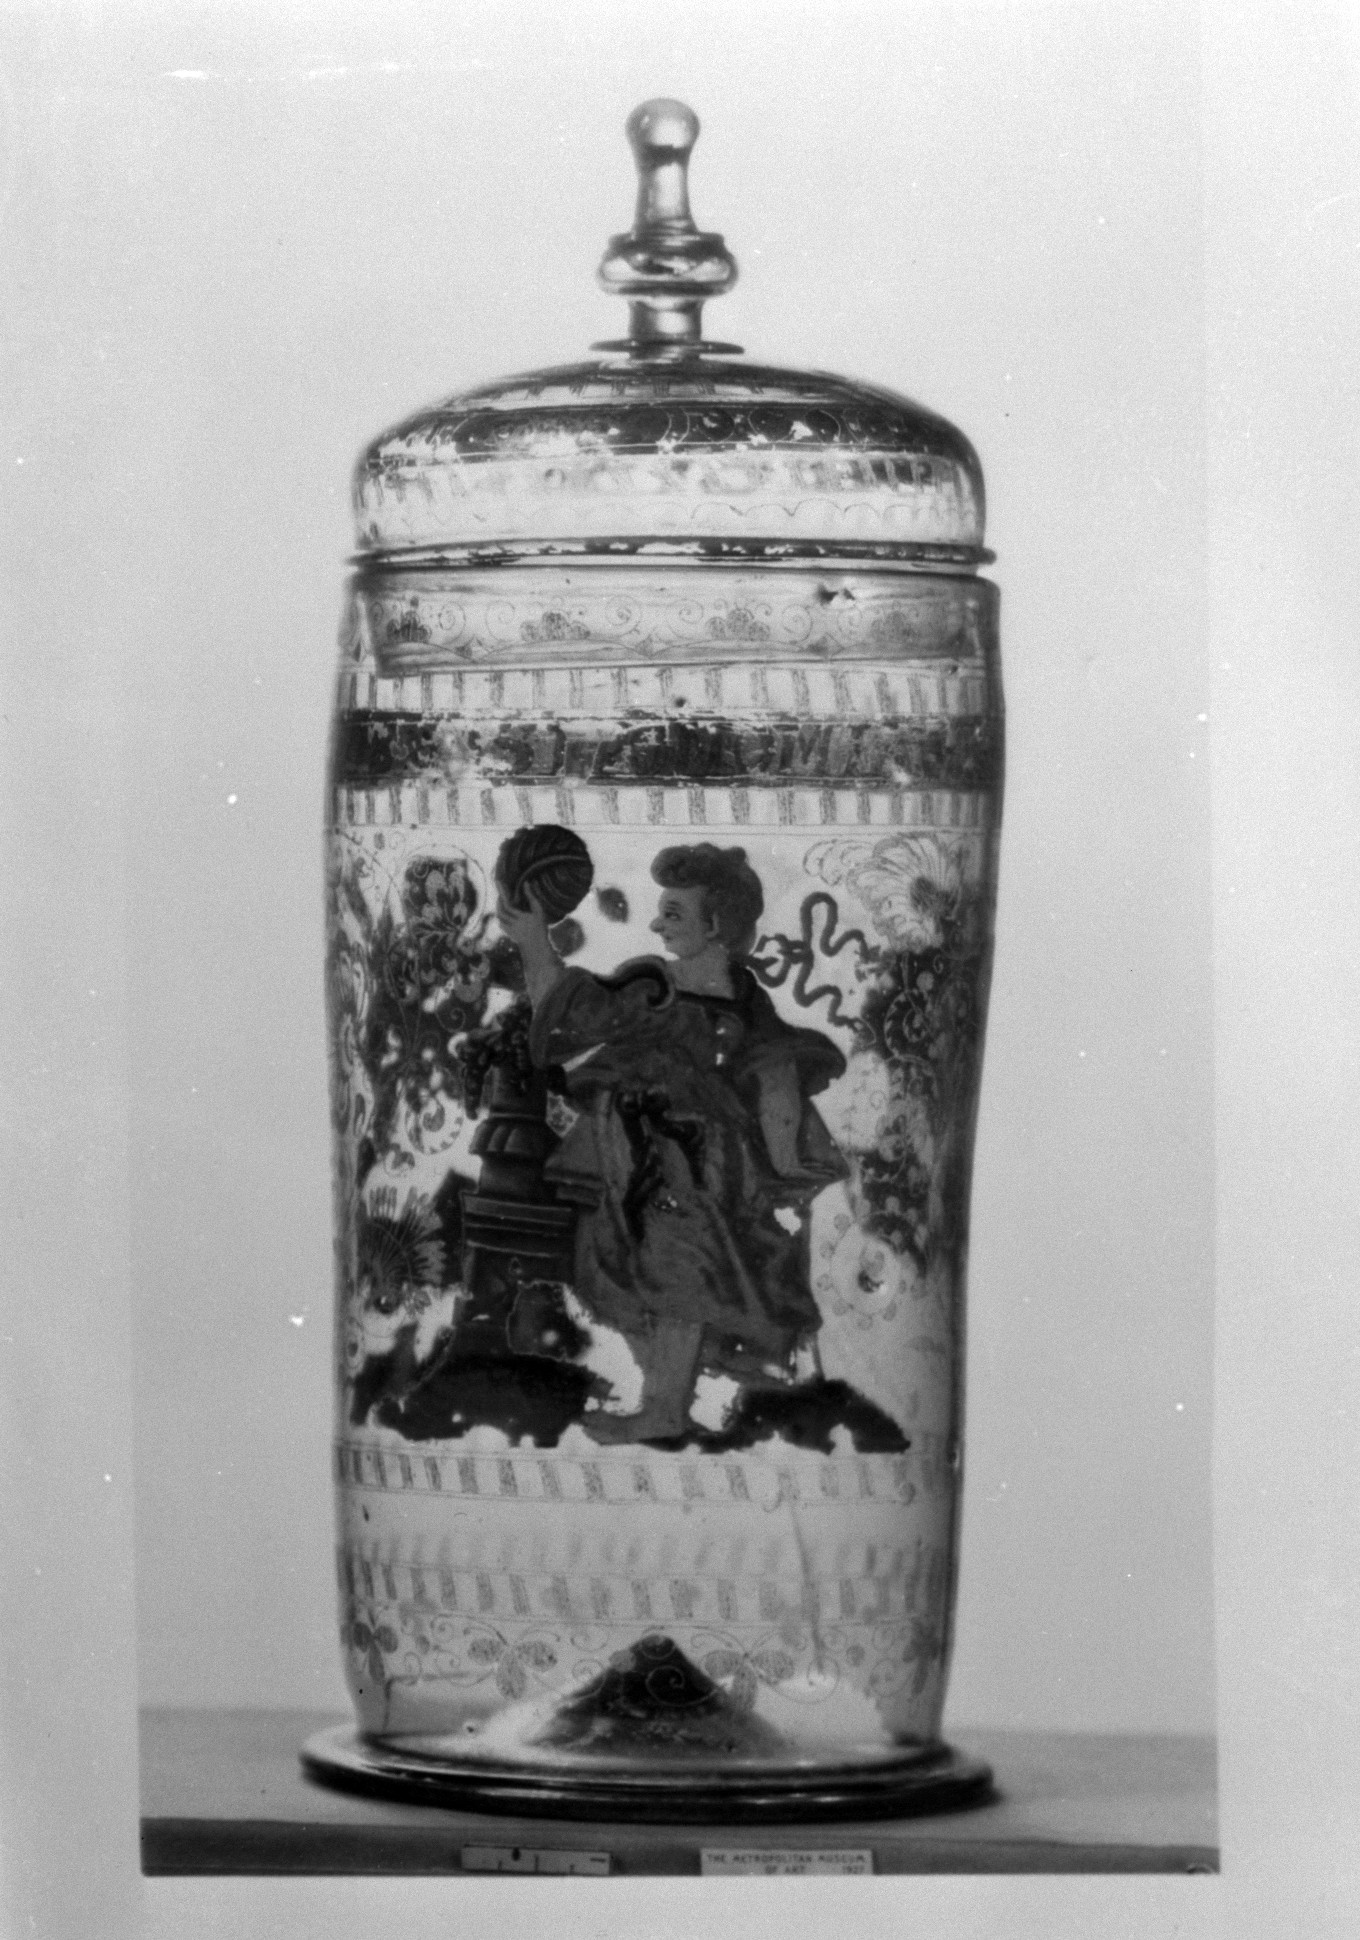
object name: beaker with cover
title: Beaker with cover (Humpen)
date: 1668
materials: glass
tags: men